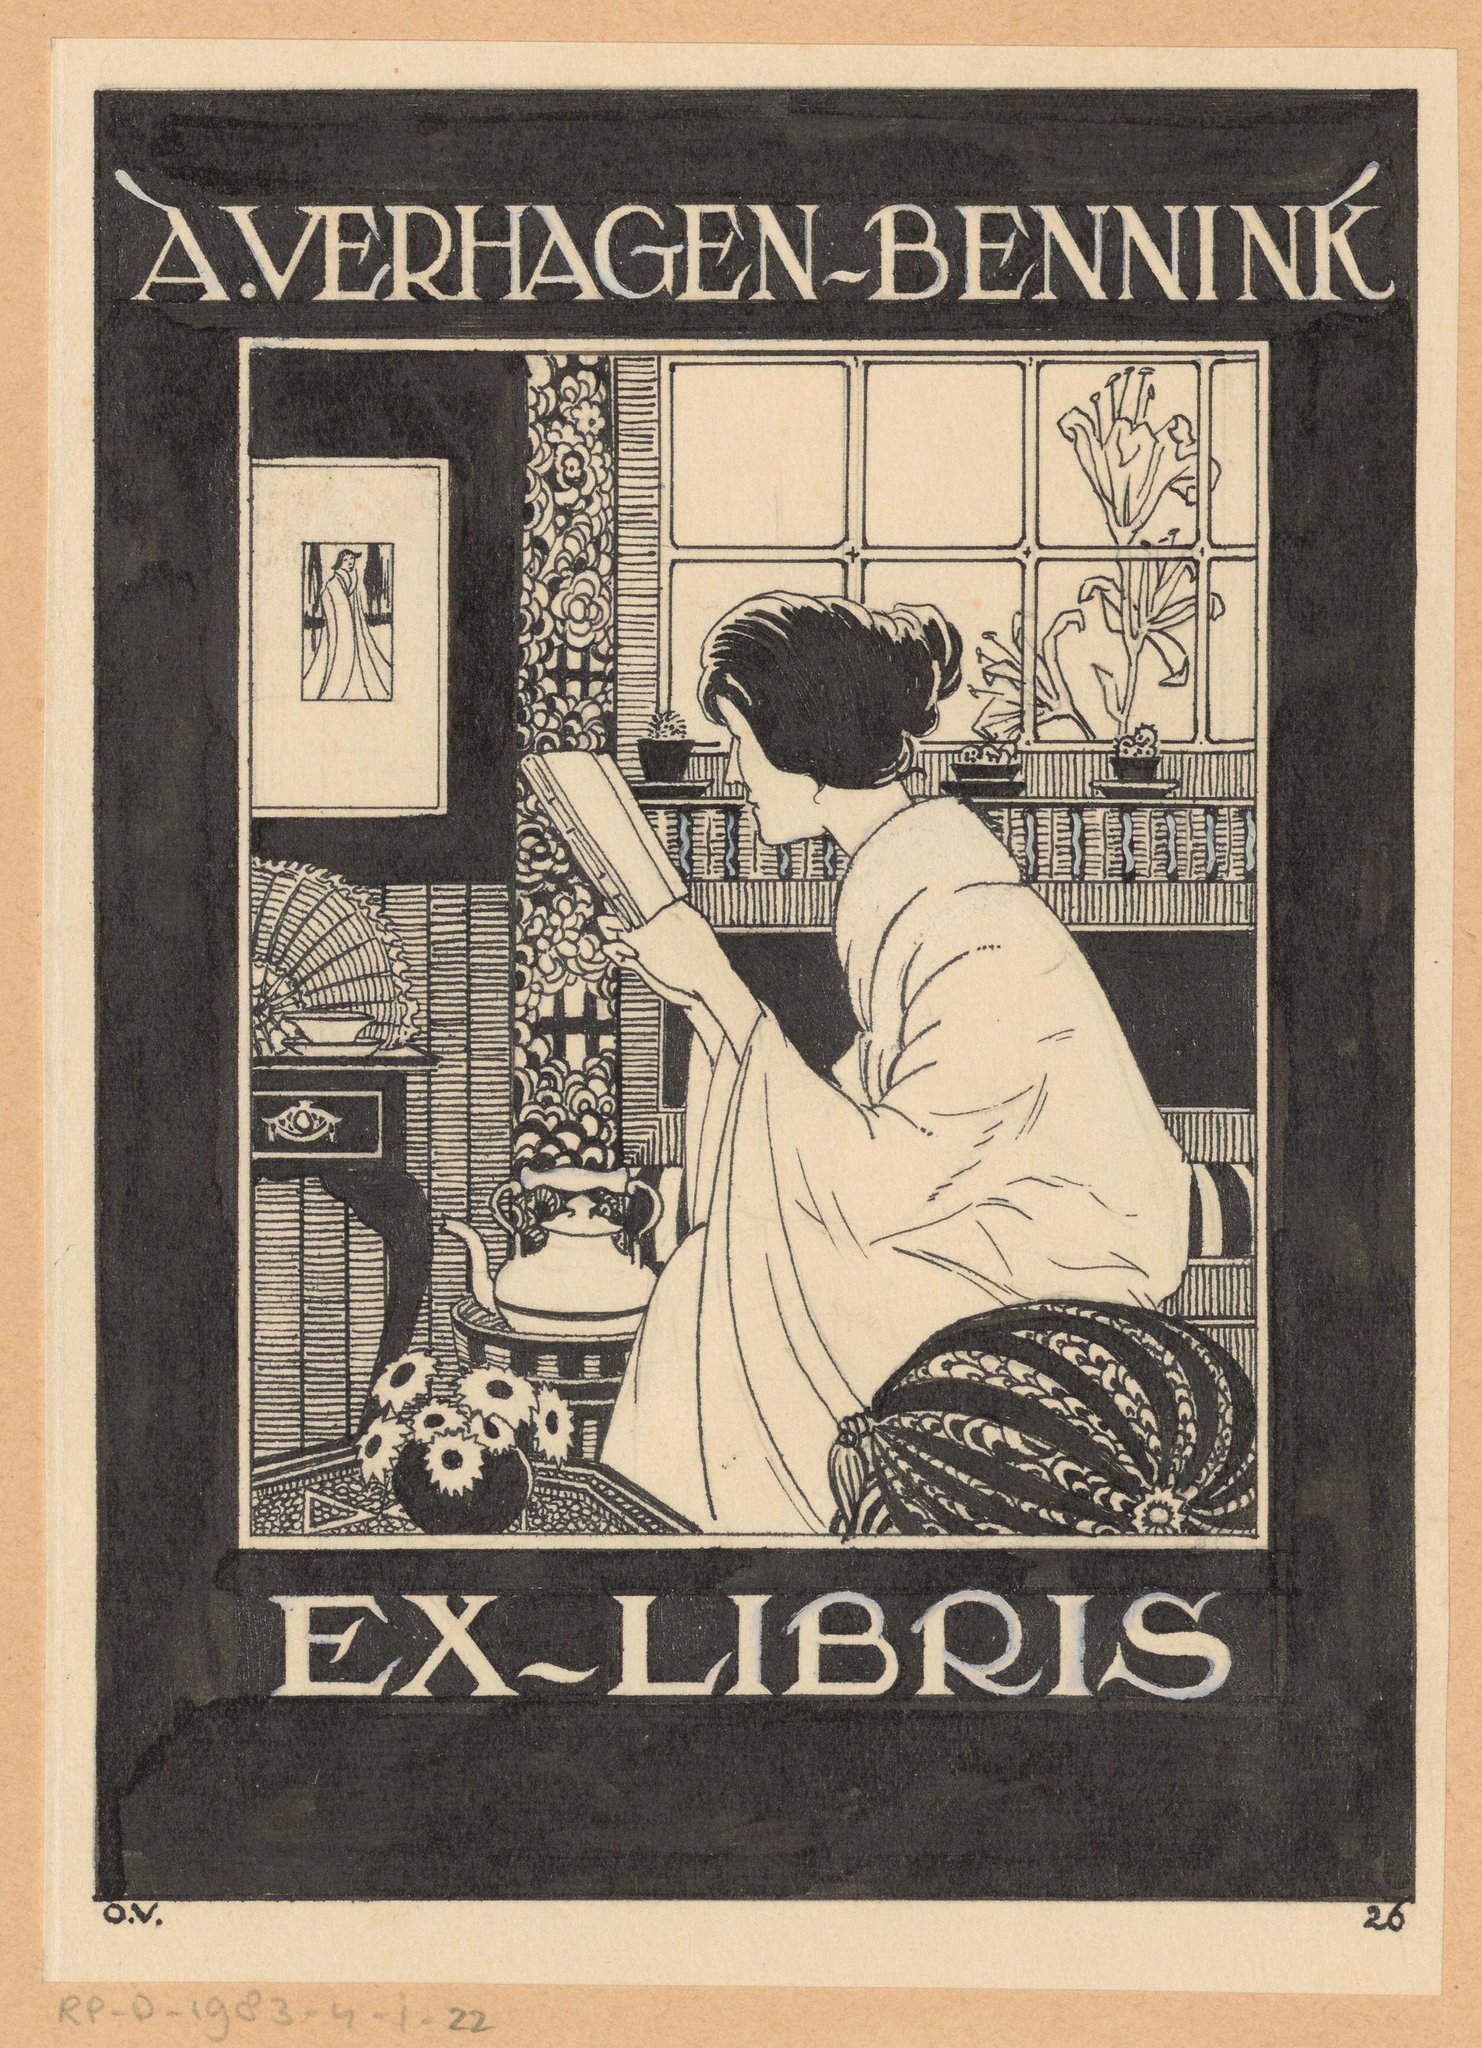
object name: bookplate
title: Ex-libris A. Verhagen-Bennink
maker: otto verhagen (i)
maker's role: draughtsman, print maker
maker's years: 1885-1951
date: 1926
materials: paint, ink, paper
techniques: drawing, pen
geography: netherlands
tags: sitting figure - aa - female human figure, book, tea-pot; samovar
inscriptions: inscription: ‘Clichédruk - jaar 1926 (...) 1930 Los Angeles.’